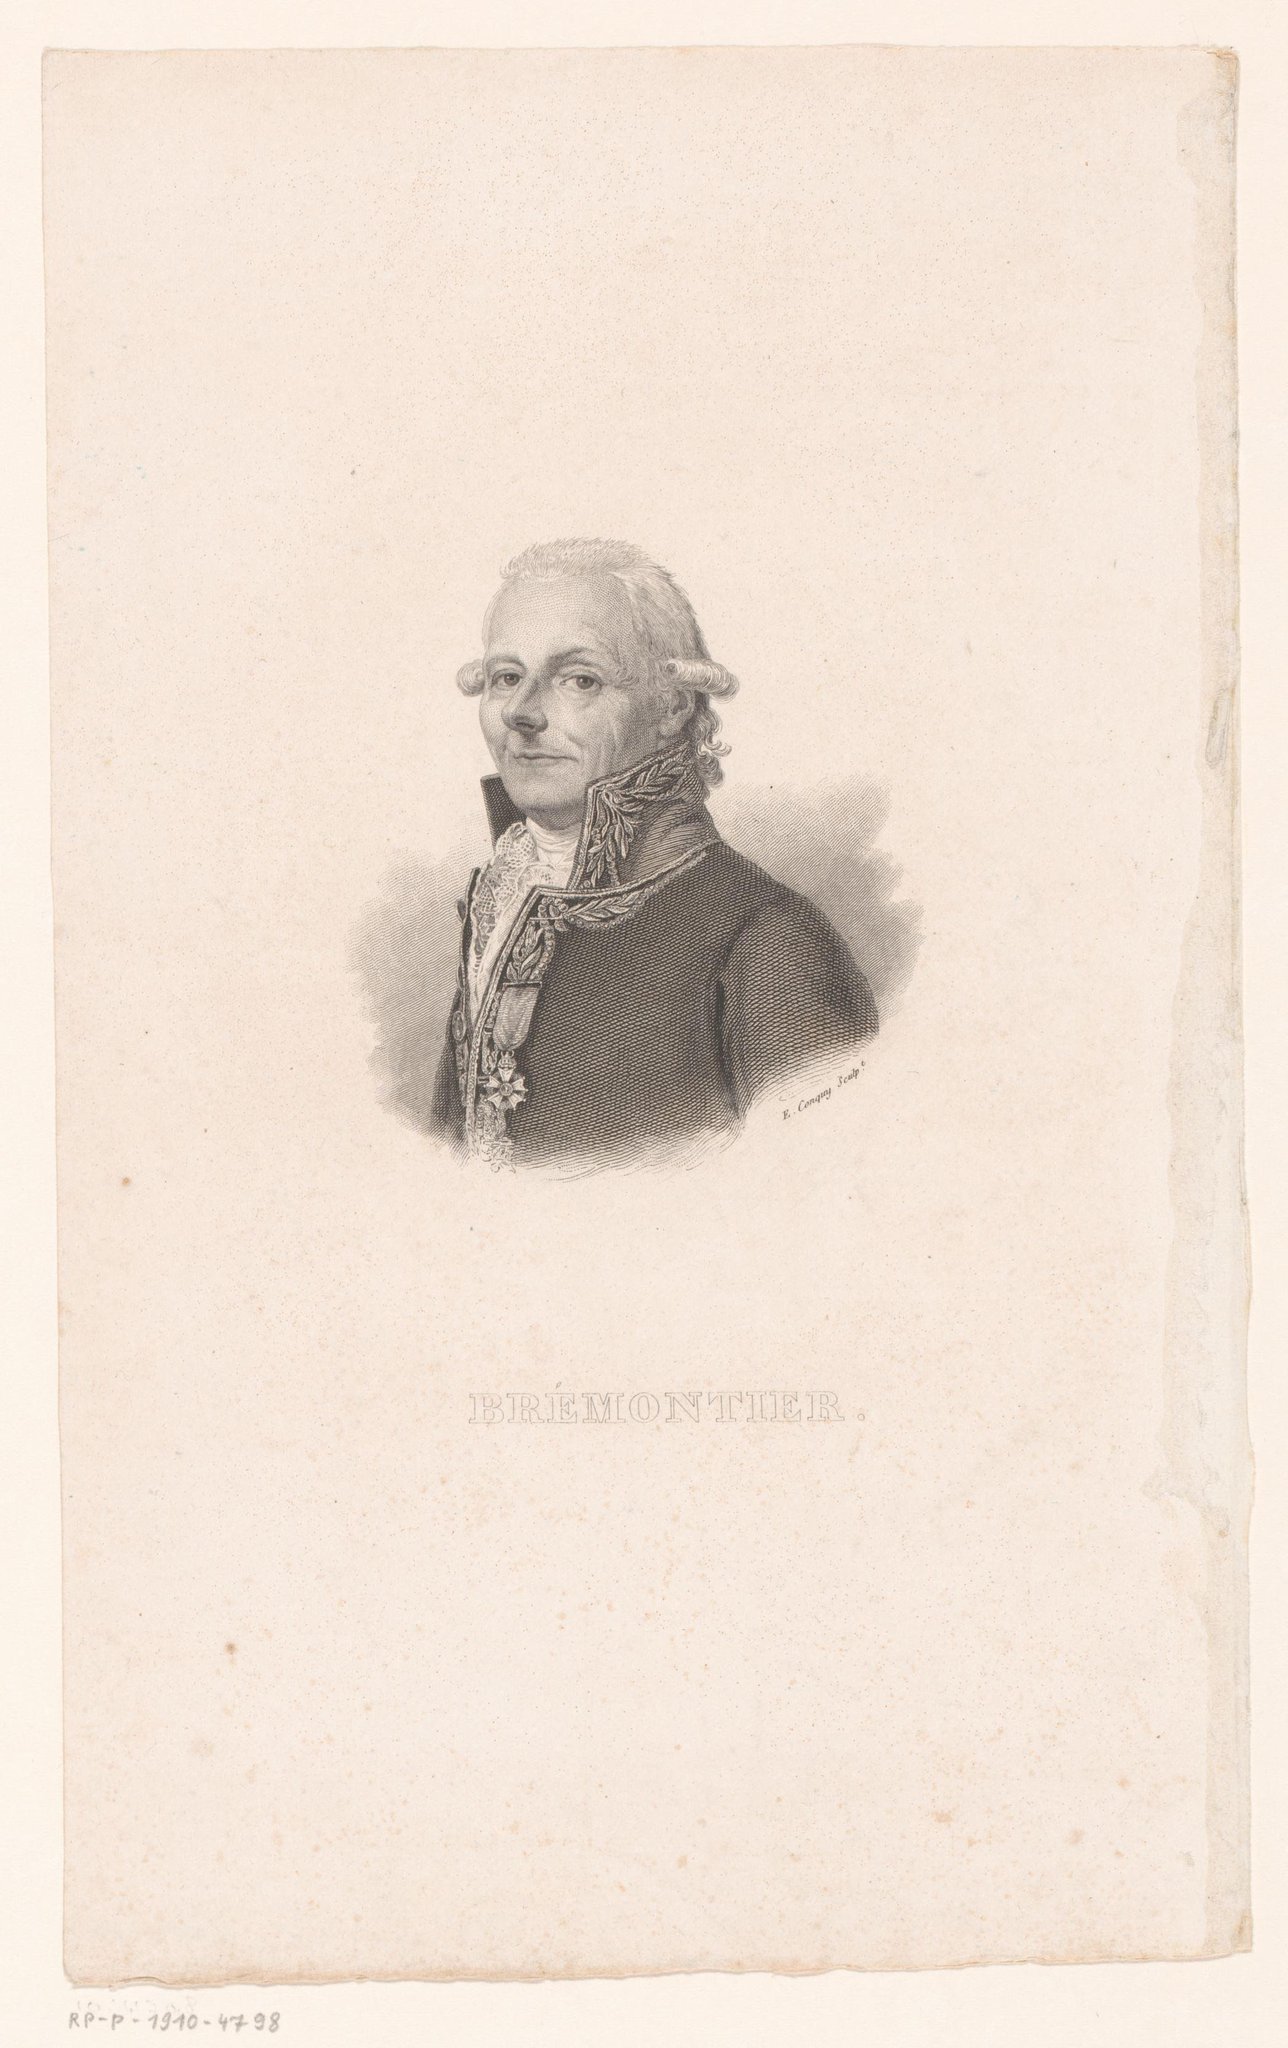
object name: print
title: Brémontier.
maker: ephraïm conquy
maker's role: print maker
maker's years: 1809-1843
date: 1819-1843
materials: paper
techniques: engraving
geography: france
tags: paris, engineer, historical persons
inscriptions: collector's mark: Lugt 2228